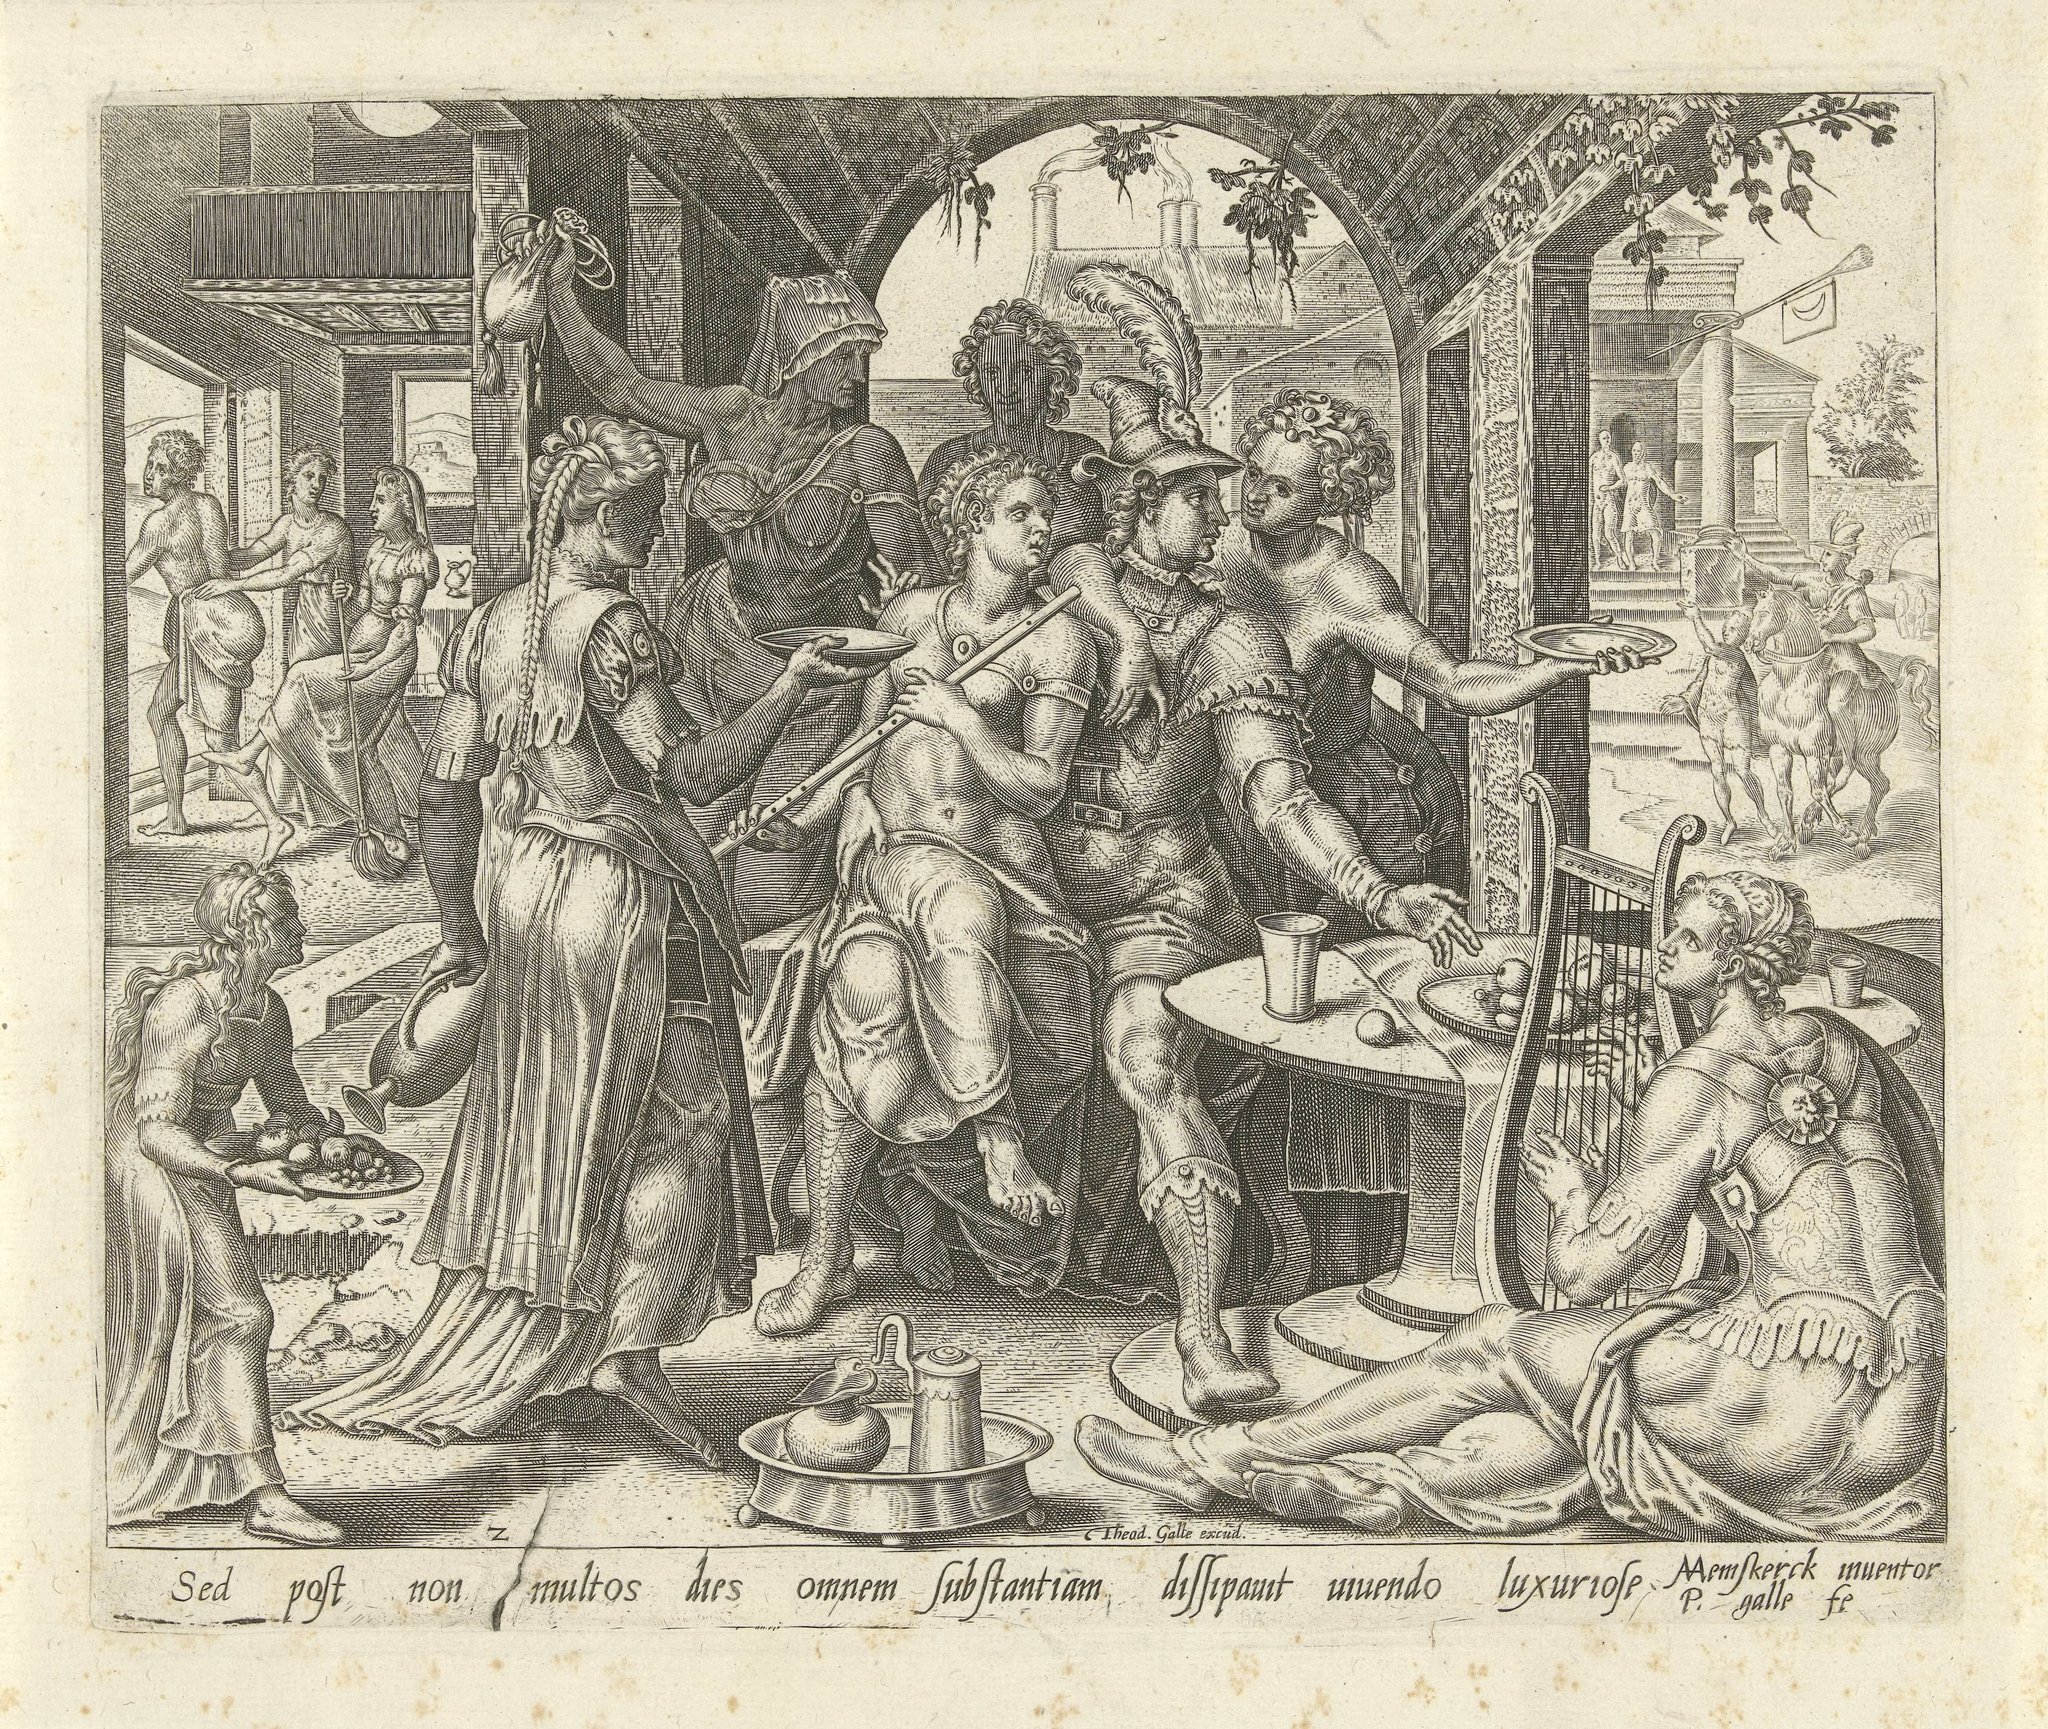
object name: print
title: De verloren zoon verkwist zijn erfenis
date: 1596-1633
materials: paper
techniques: engraving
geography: haarlem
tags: when all his money is squandered the prodigal son is chased away by the harlots, the prodigal son in the midst of prostitutes feasting and dissipating his patrimony, usually in a brothel or inn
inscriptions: collector's mark: ‘AP 199’, collector's mark: Lugt 2228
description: De verloren zoon verkwist zijn erfenis in een bordeel. Zeven vrouwen omzorgen hem, maken muziek voor hem en brengen hem eten en drinken. Rechts is door het raam te zien hoe de verloren zoon arriveert, links is te zien hoe hem, nadat het geld op is, de deur gewezen wordt.